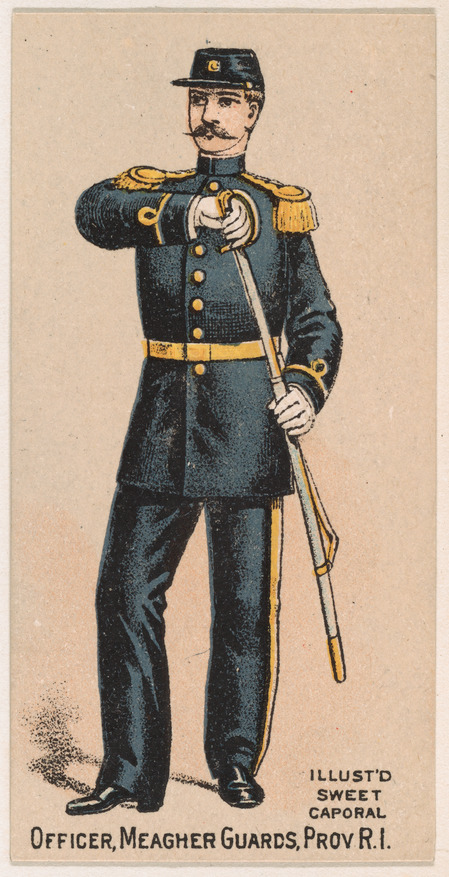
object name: print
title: Officer, Meagher Guards, Providence, Rhode Island, from the Military Series (N224) issued by Kinney Tobacco Company to promote Sweet Caporal Cigarettes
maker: kinney brothers tobacco company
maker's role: publisher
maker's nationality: american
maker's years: 1869-2011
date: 1888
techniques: color lithograph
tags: soldiers,swords,men